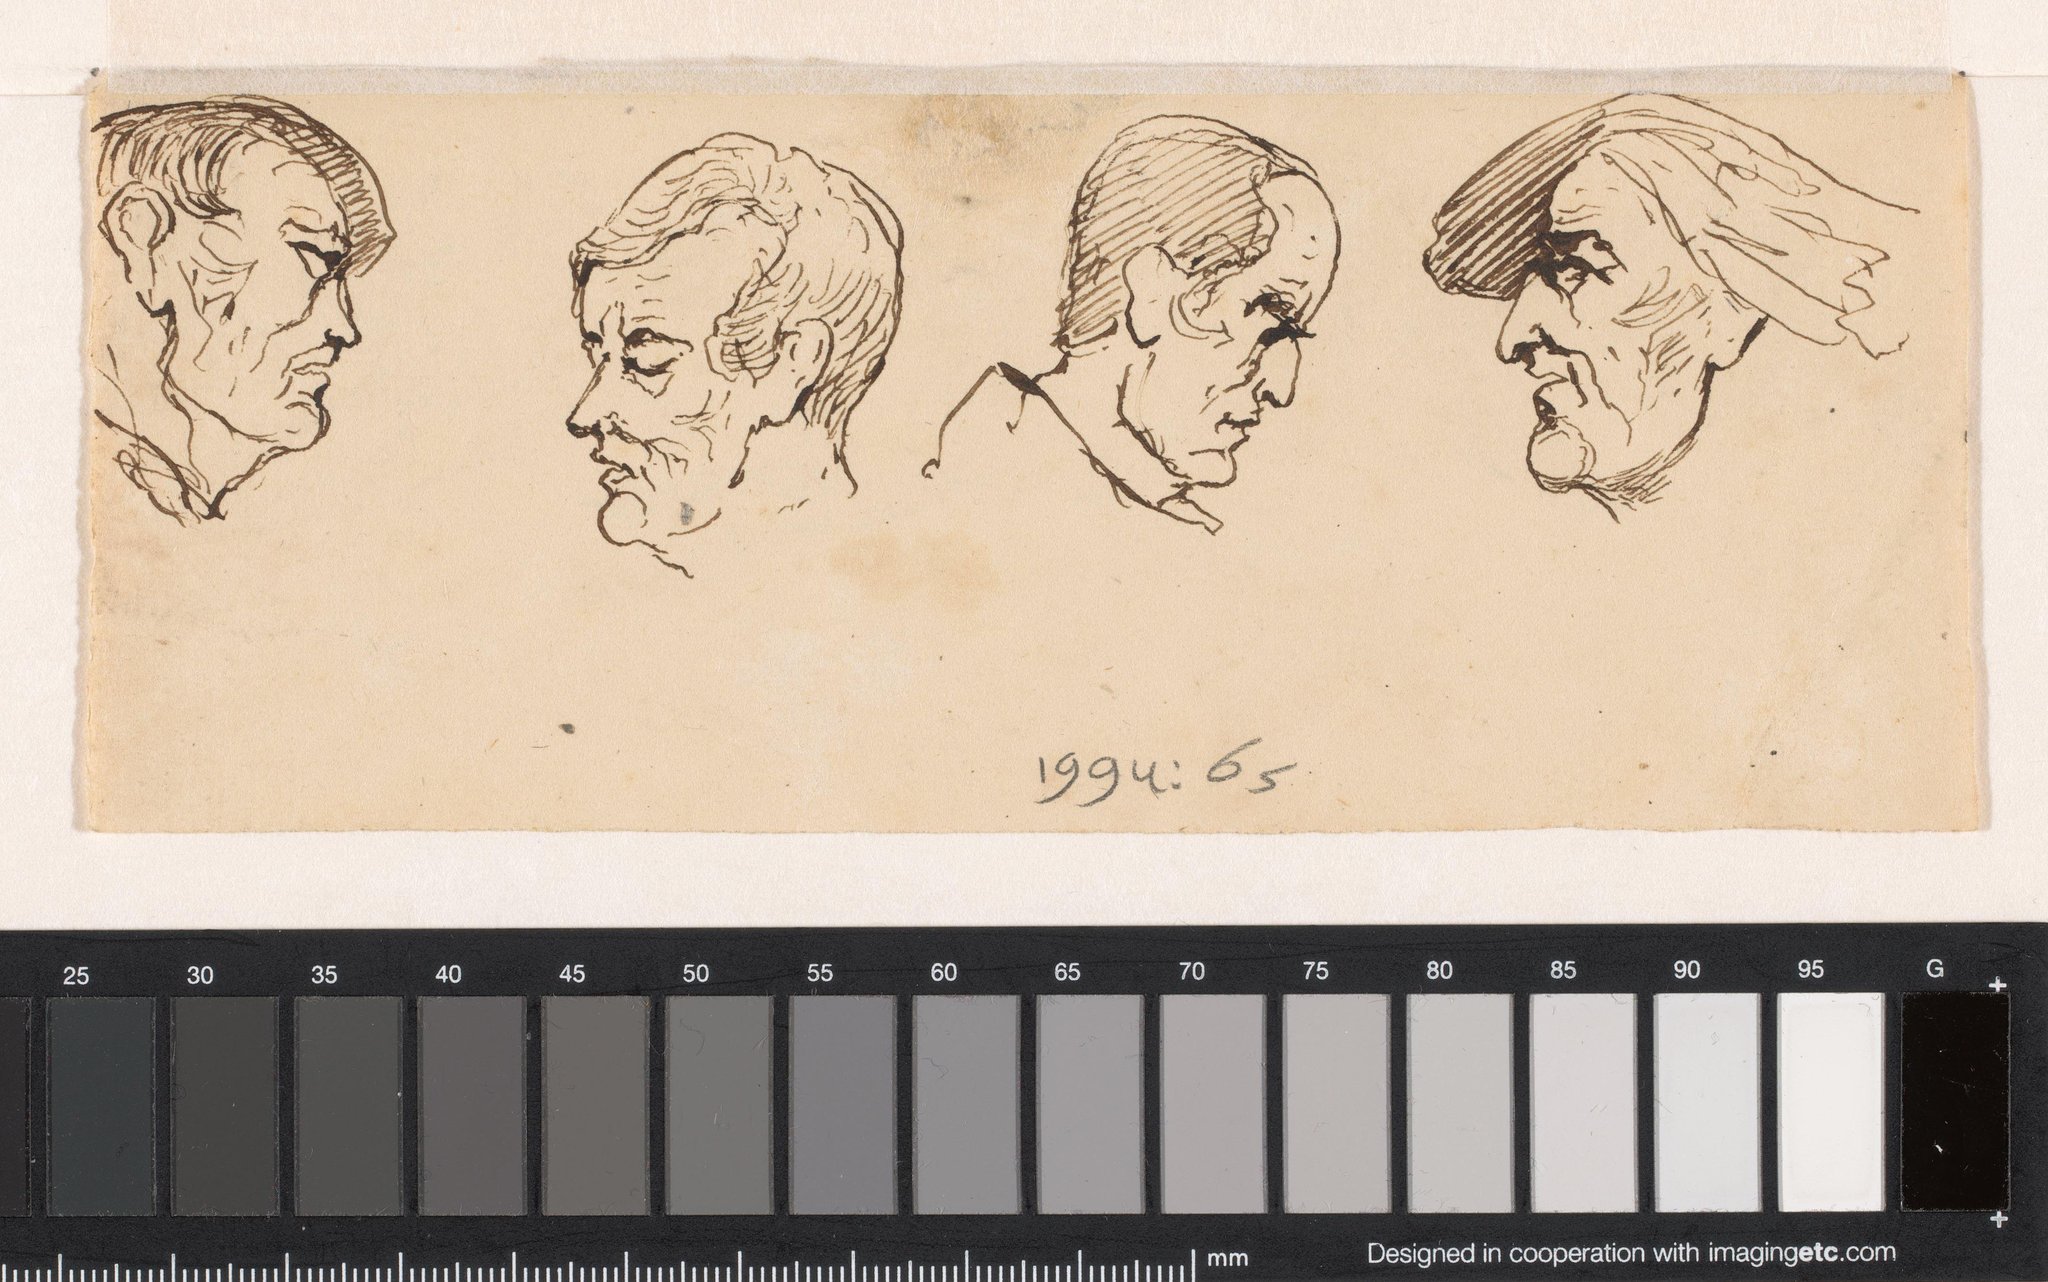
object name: drawing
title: Vier mannenkoppen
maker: johannes tavenraat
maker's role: draughtsman, painter, print maker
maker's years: 1809-1881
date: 1819-1881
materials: ink, paper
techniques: pen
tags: head (human)